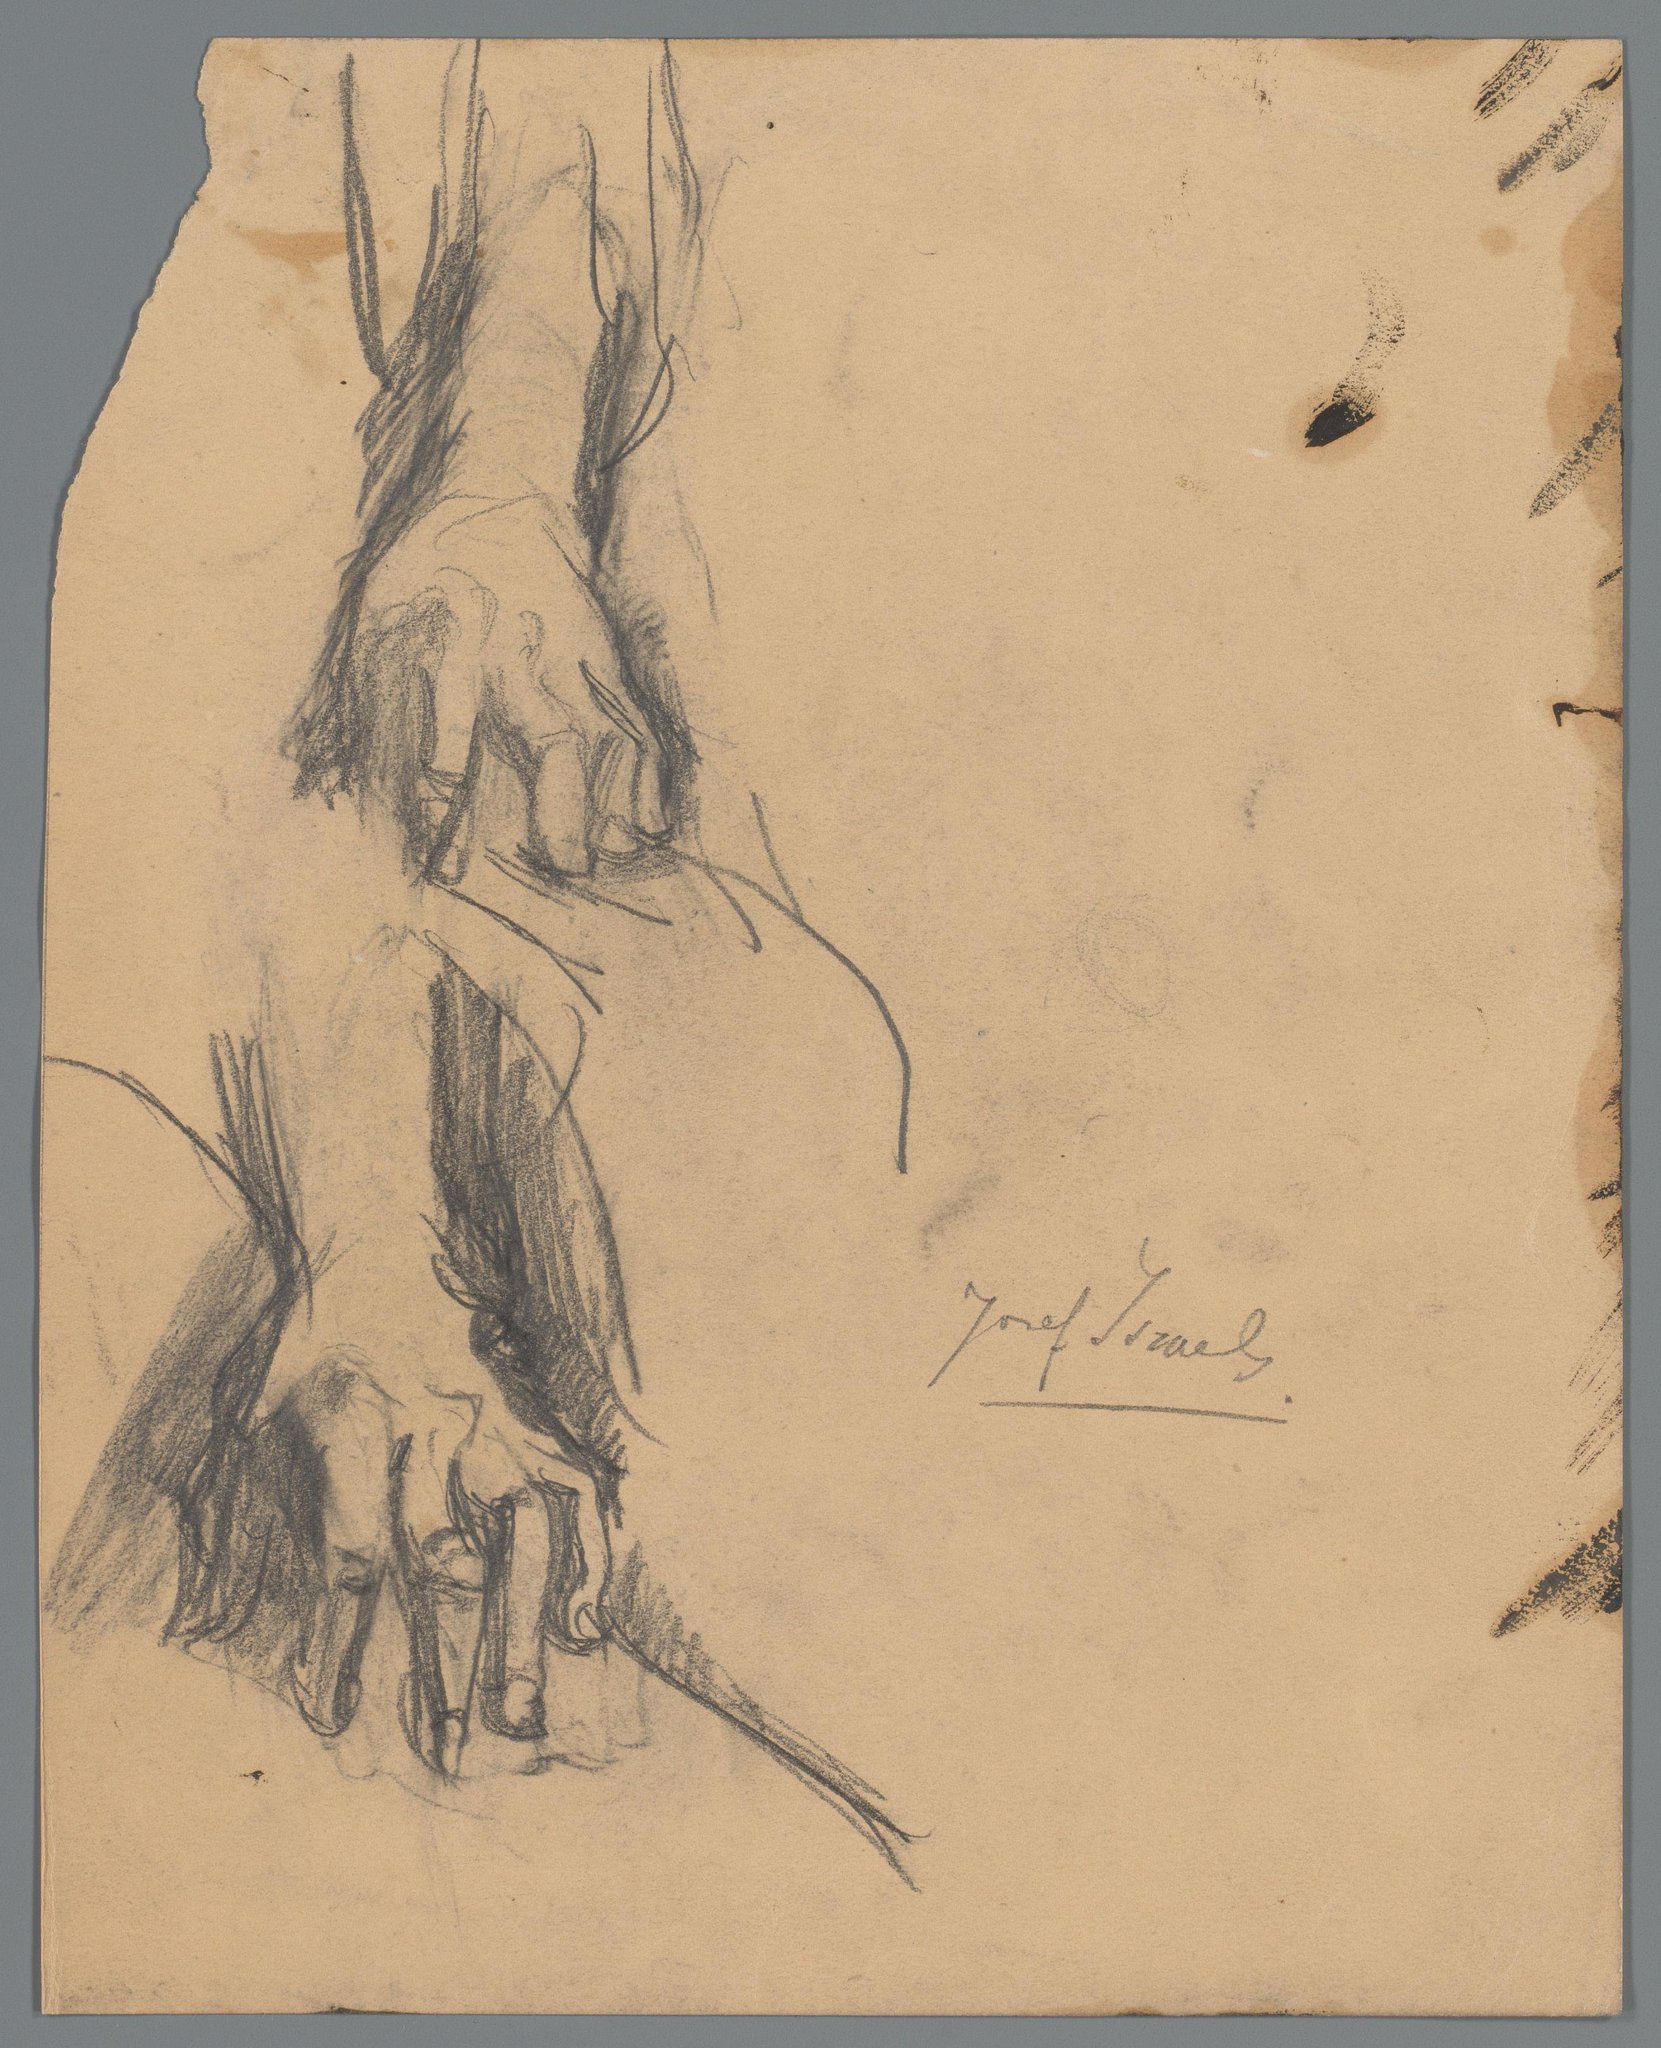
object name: drawing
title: Paar handen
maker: jozef israëls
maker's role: draughtsman, painter, print maker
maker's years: 1824-1911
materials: paper, pencil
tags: hand